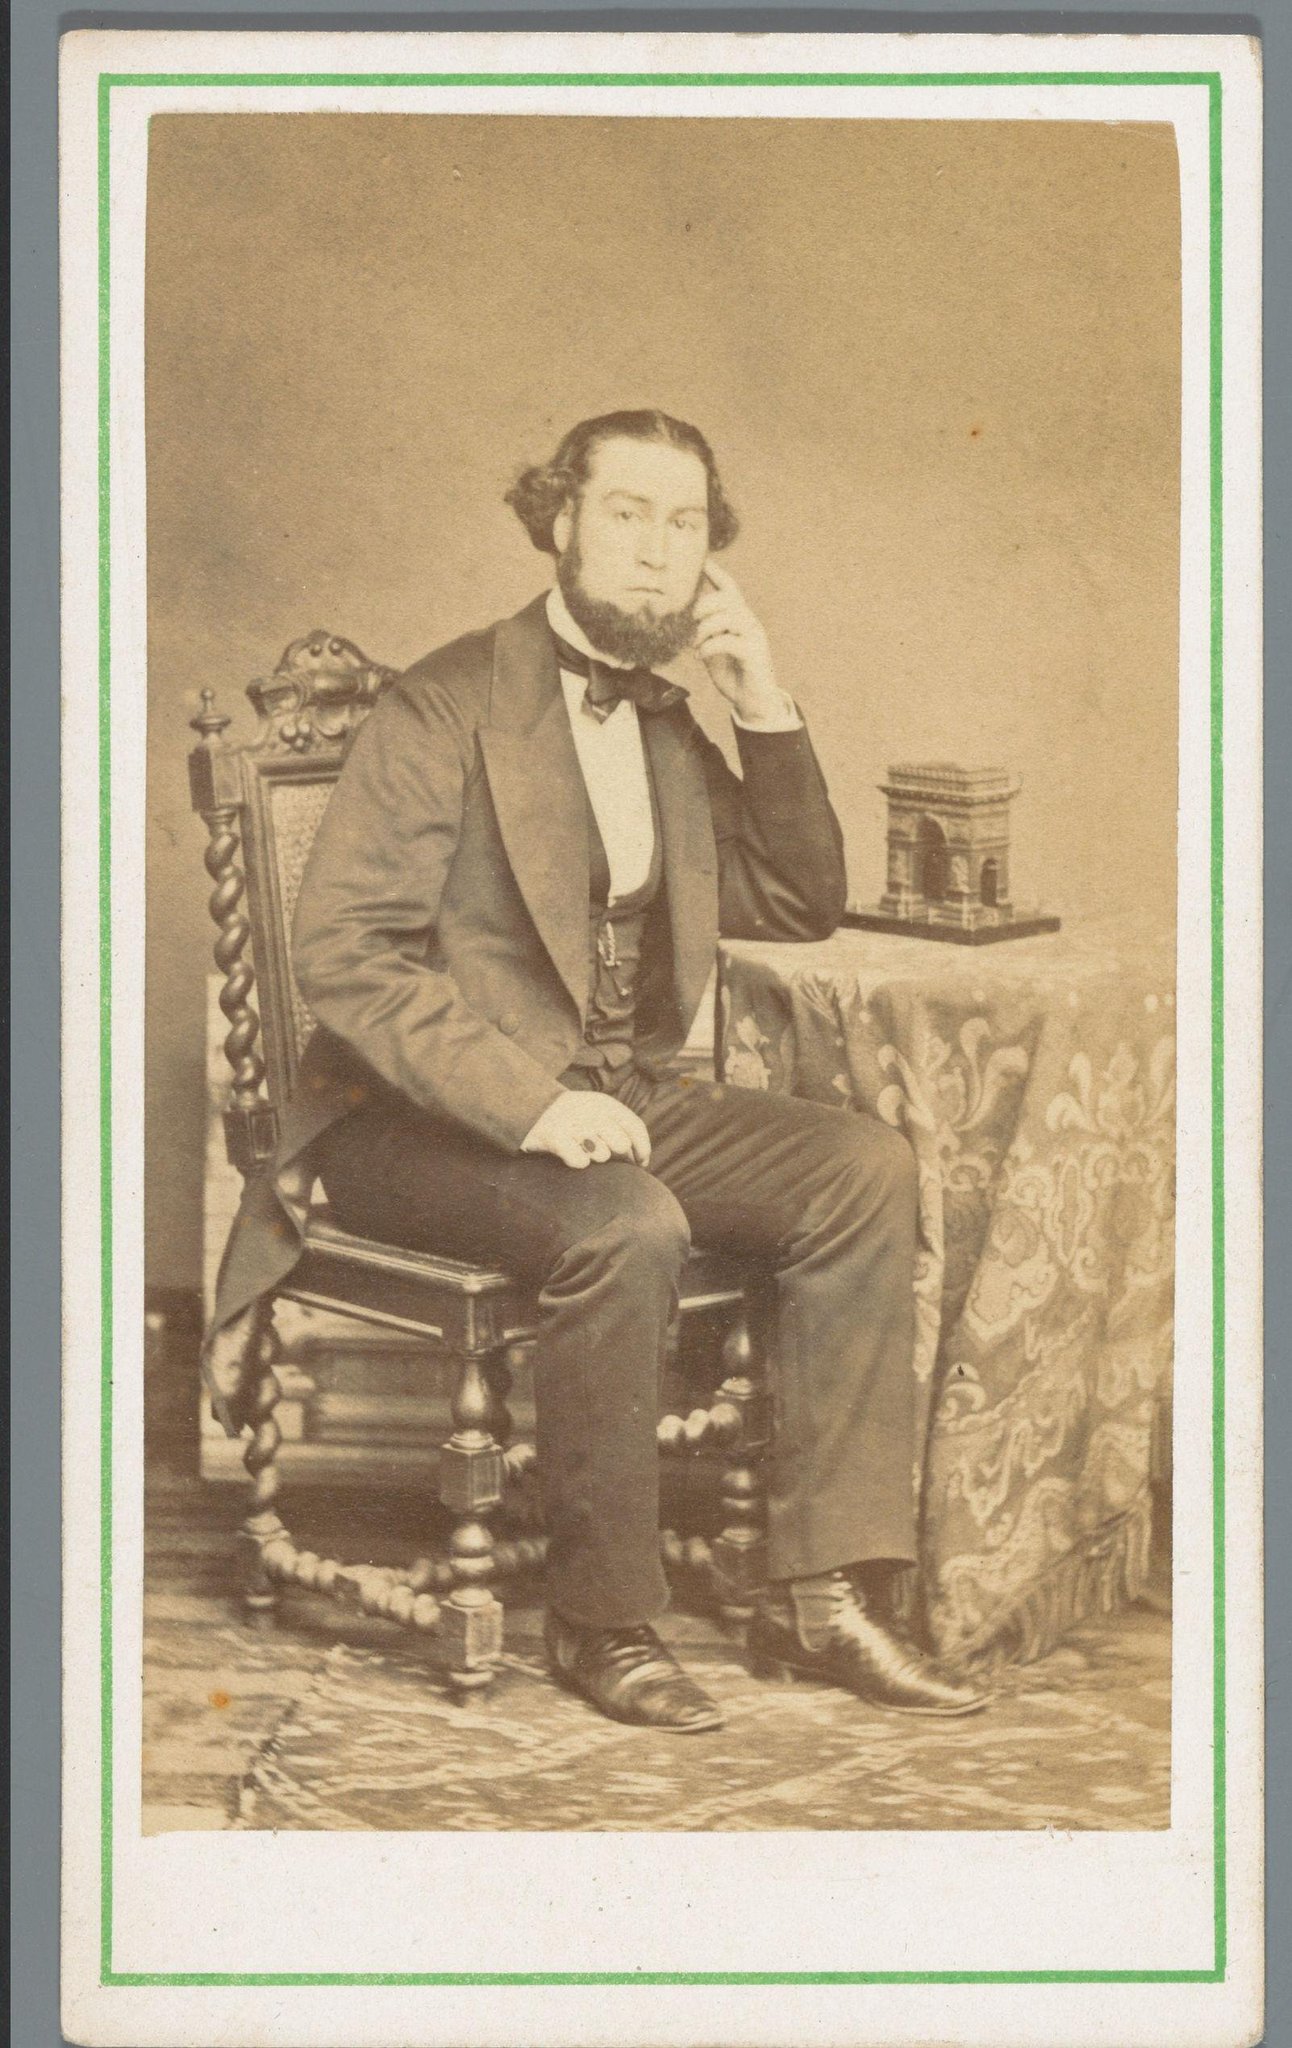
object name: photograph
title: Portret van M. Boulet Desbareau bij een model van de Arc de Triomphe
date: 1855-1885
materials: cardboard, paper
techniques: albumen print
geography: le havre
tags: adult man, historical persons, le havre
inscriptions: inscription: ‘M. Boulet Desbareau’, inscription: ‘Evrard & Cie./ Photographie havraise/ 97, Boulevard Impérial, 97/ Hâvre’